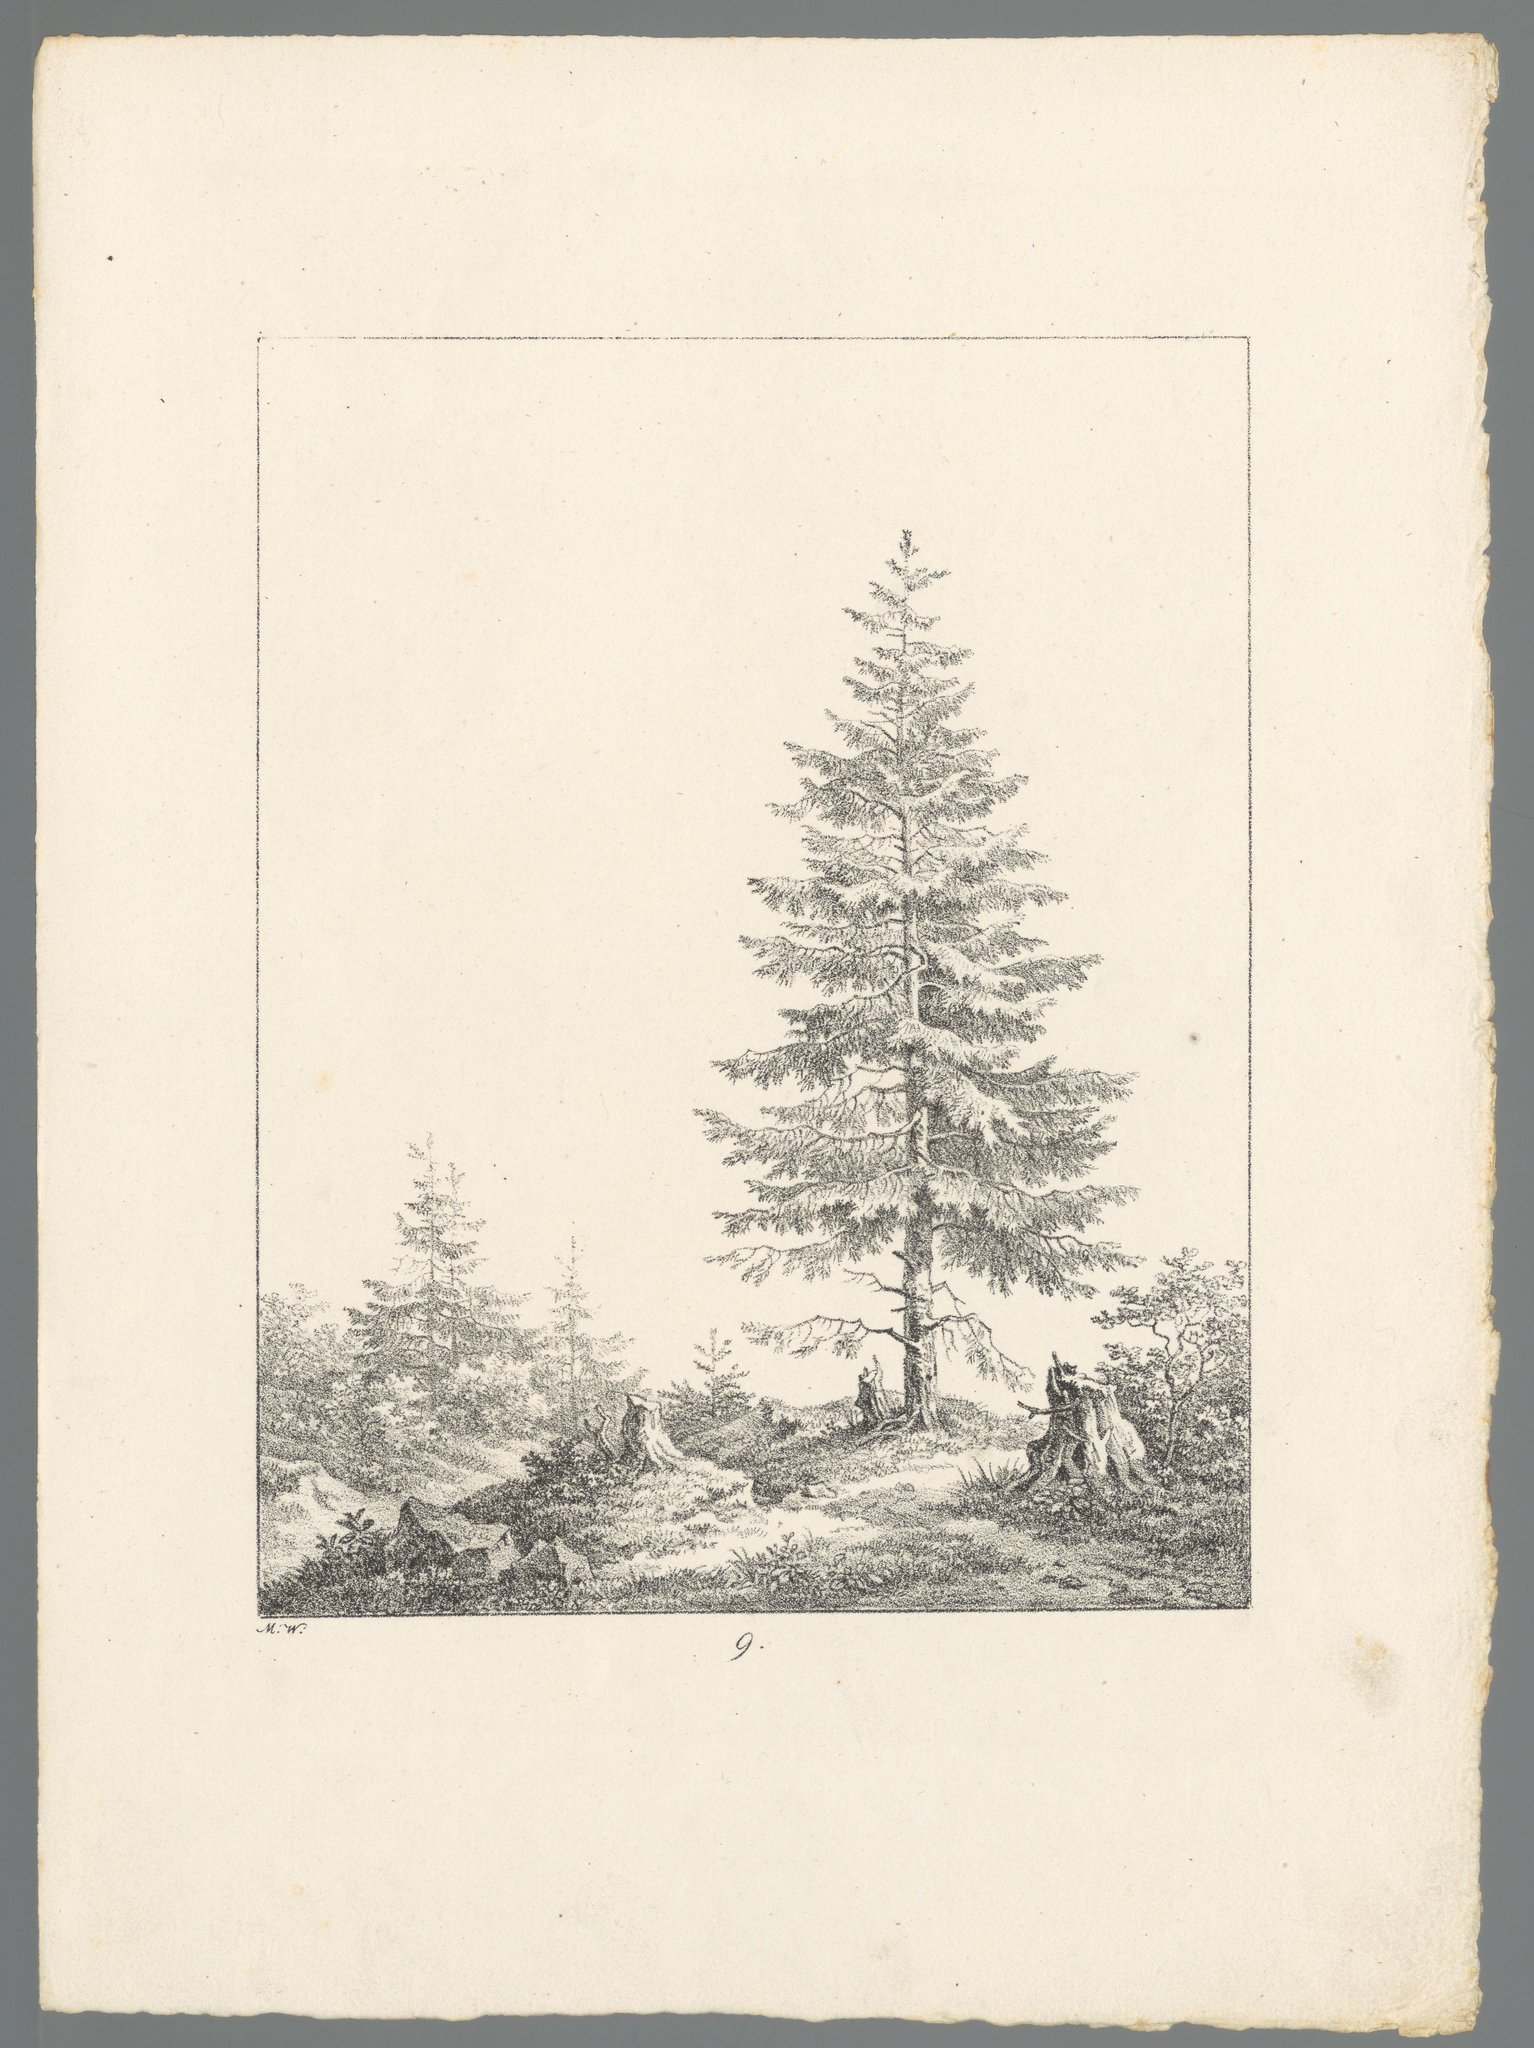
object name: print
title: Vorlagen für Landschaft-zeichner, I Heft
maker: max josef wagenbauer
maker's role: print maker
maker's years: 1774-1829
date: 1823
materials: paper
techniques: lithograph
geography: munich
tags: landscapes in the temperate zone, trees: pine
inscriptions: collector's mark: Lugt 2228, collector's mark: Lugt 2760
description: Prent behoort tot het eerste deel van de serie 'Vorlagen für Landschaft-zeichner'. Dit eerste deel bevat twintig prenten.